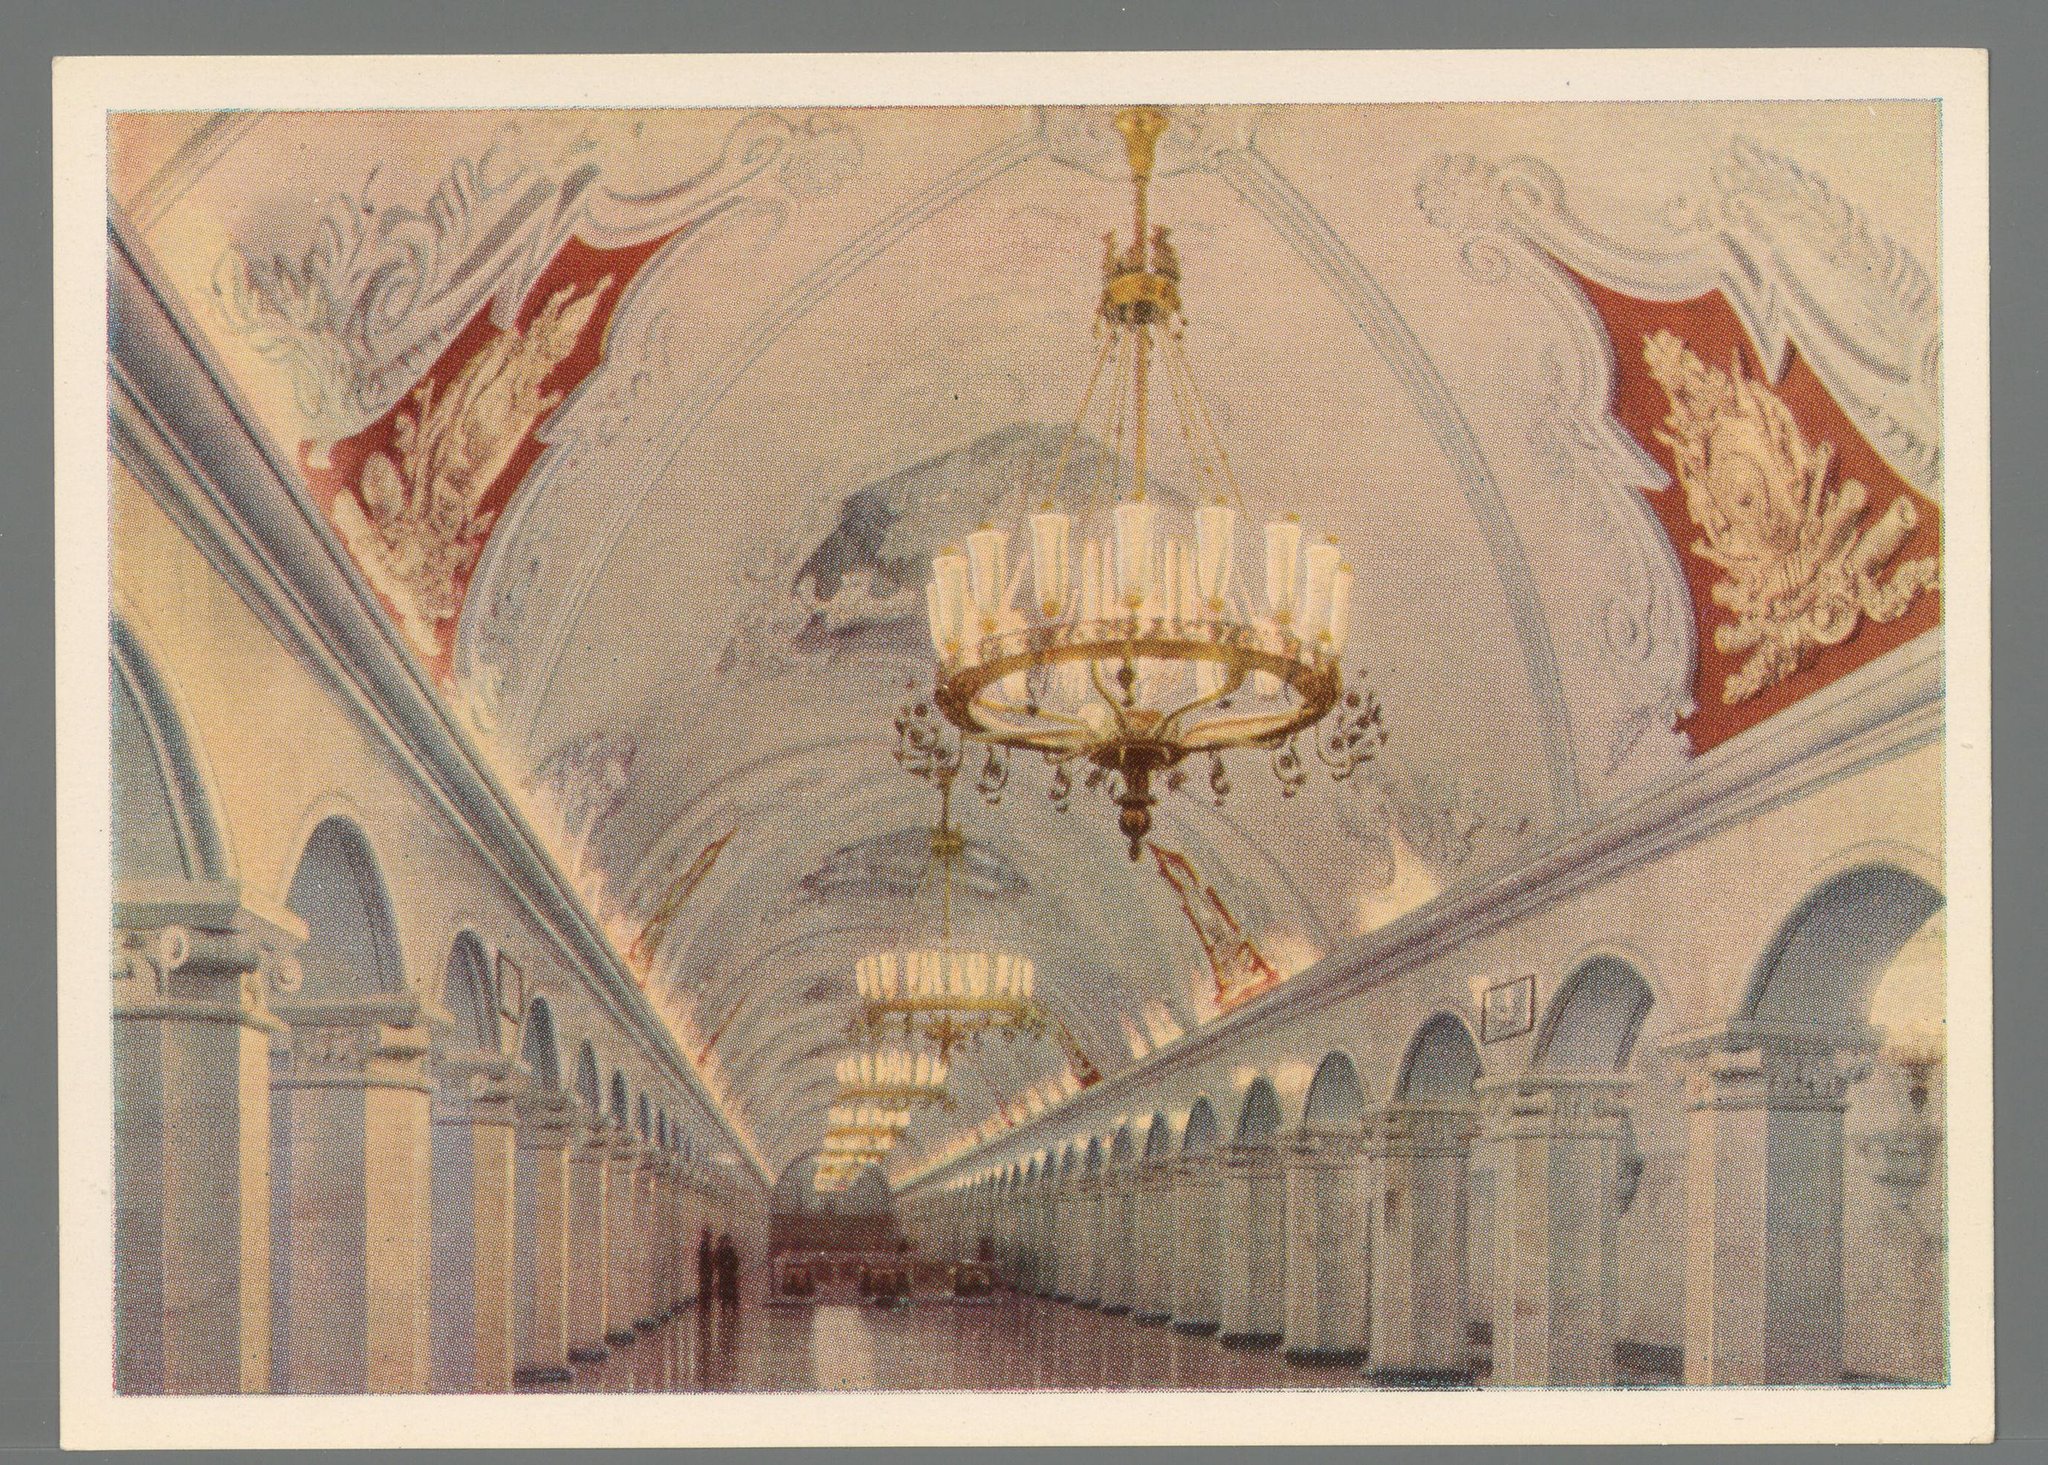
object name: ansichtkaart, prentbriefkaart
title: Moscow. "Komsomolskaya" Underground Station. (Beltline) / Moskau. Die Metro-Ringstation "Komsomolskaja" / Moscou. Station du métro "Komsomolskaïa-Circuit"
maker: Anonymous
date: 1956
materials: cardboard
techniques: color autotype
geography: moscow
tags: underground station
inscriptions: date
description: De titel op object staat ook in het Russisch.